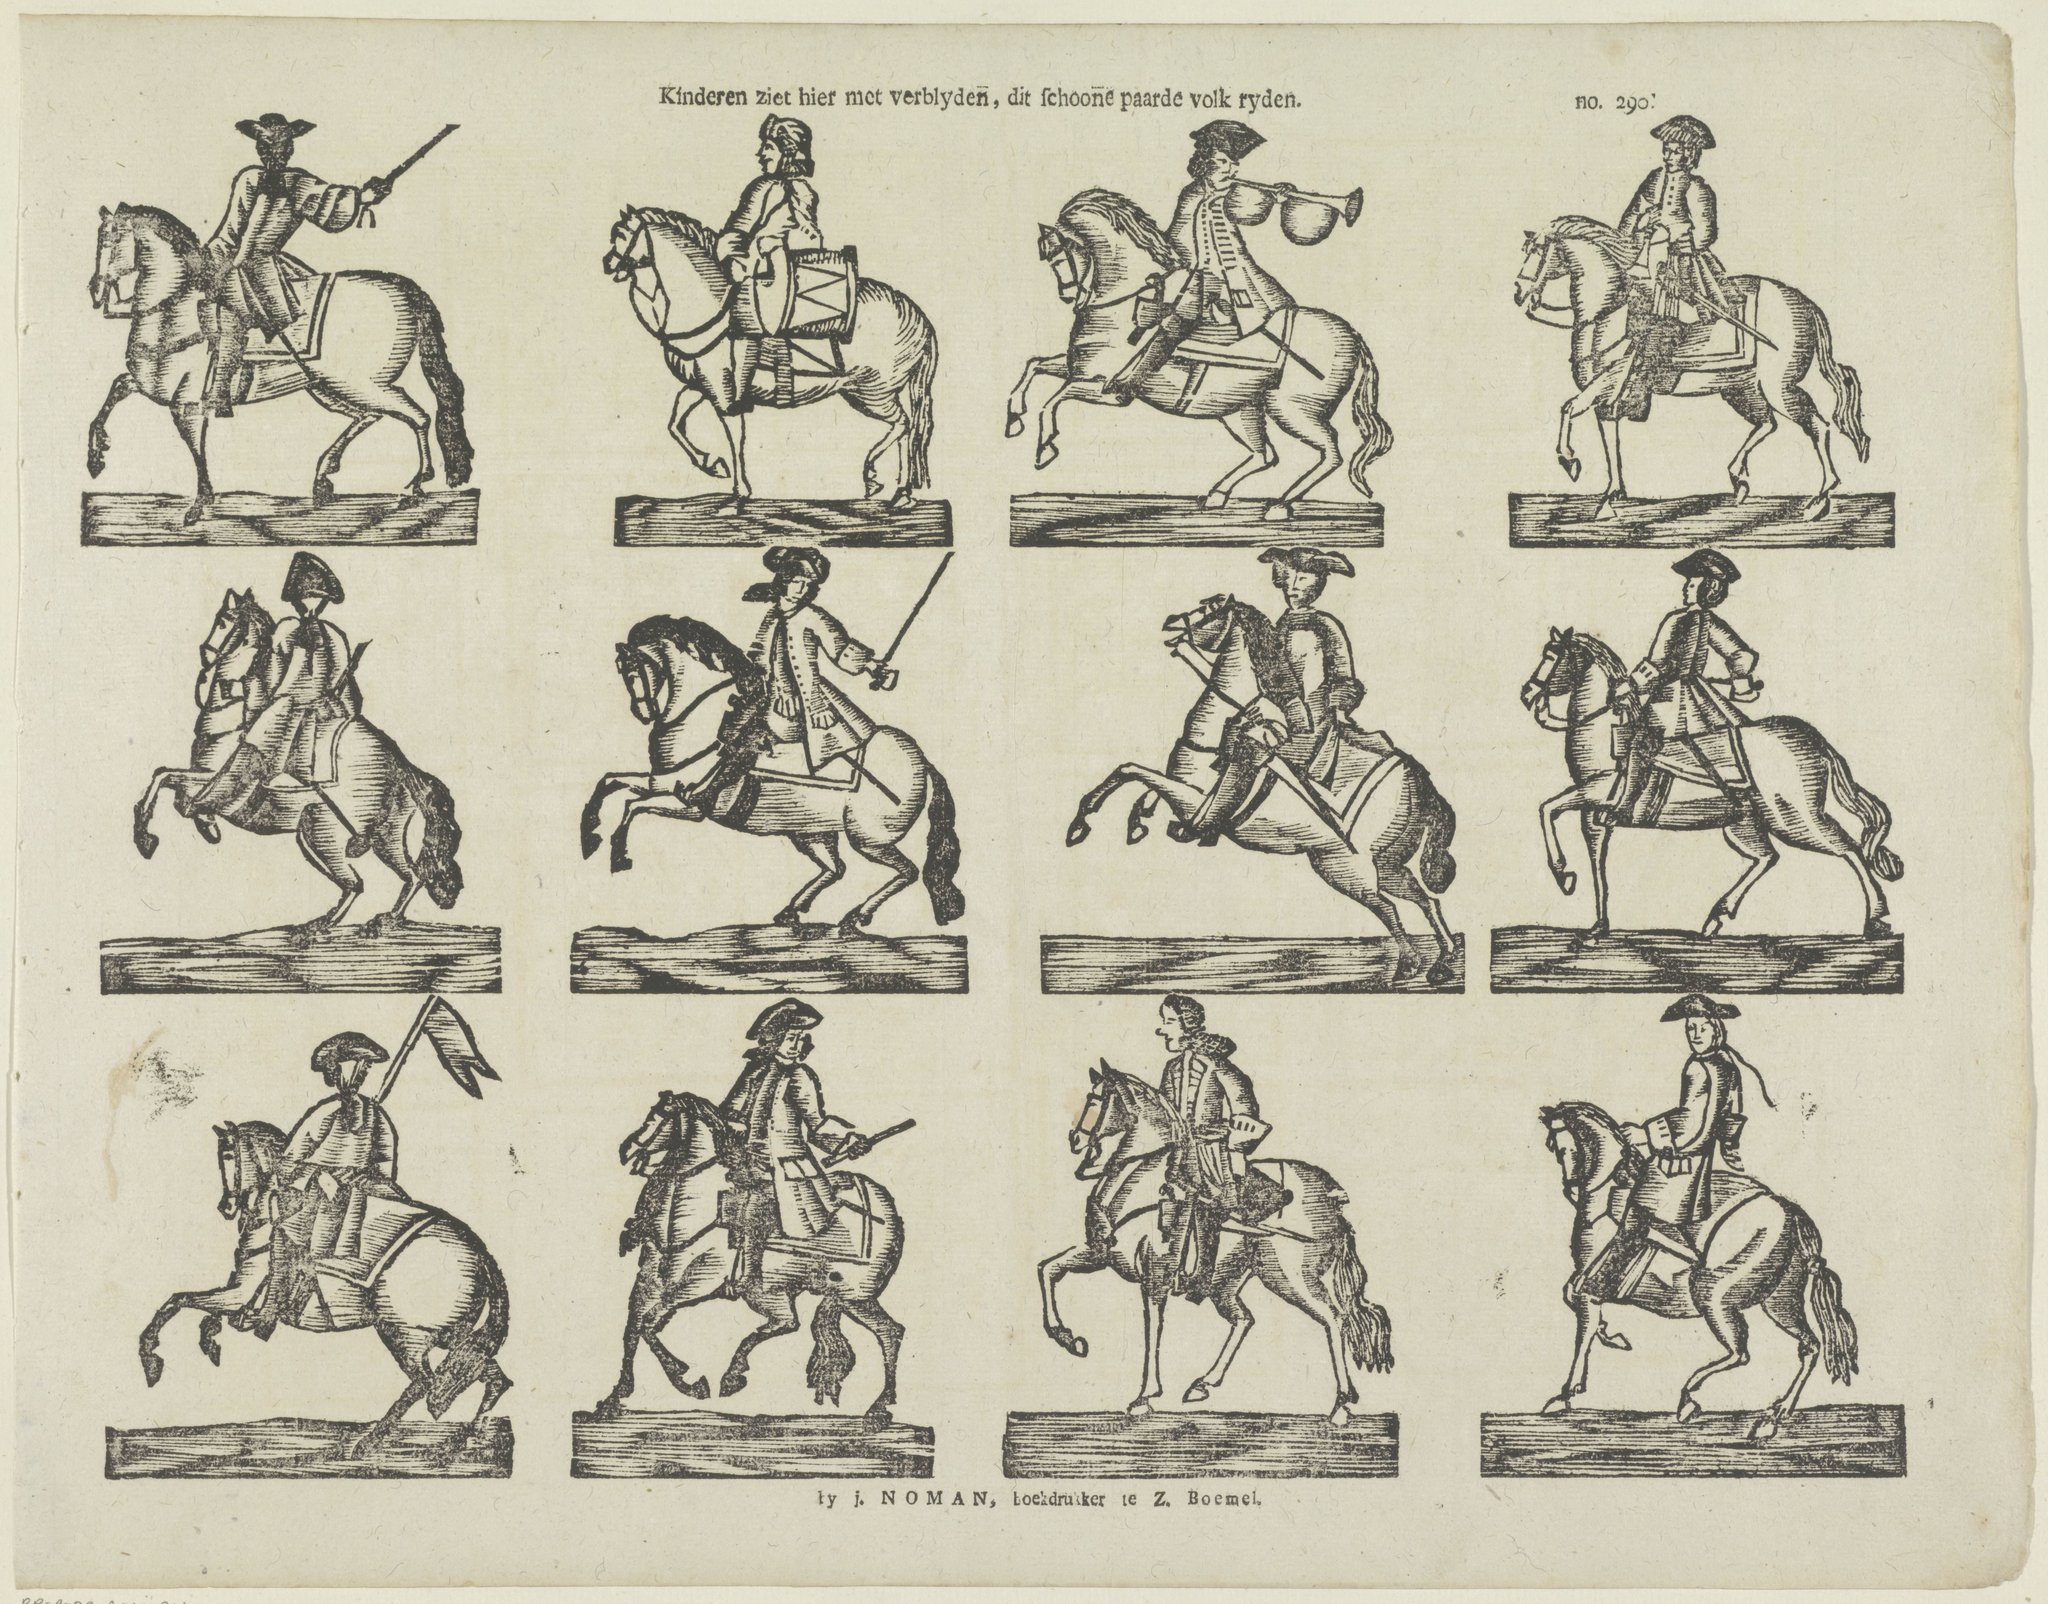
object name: print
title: Kinderen ziet hier met verblyden, dit schoone paarde volk ryden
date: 1806-1830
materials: paper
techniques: letterpress printing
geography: netherlands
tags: warfare; military affairs (+ cavalry, horsemen), the soldier; the soldier's life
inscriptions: collector's mark: Lugt 2760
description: Blad met 12 voorstellingen van militairen te paard. Genummerd rechtsboven: no. 290.